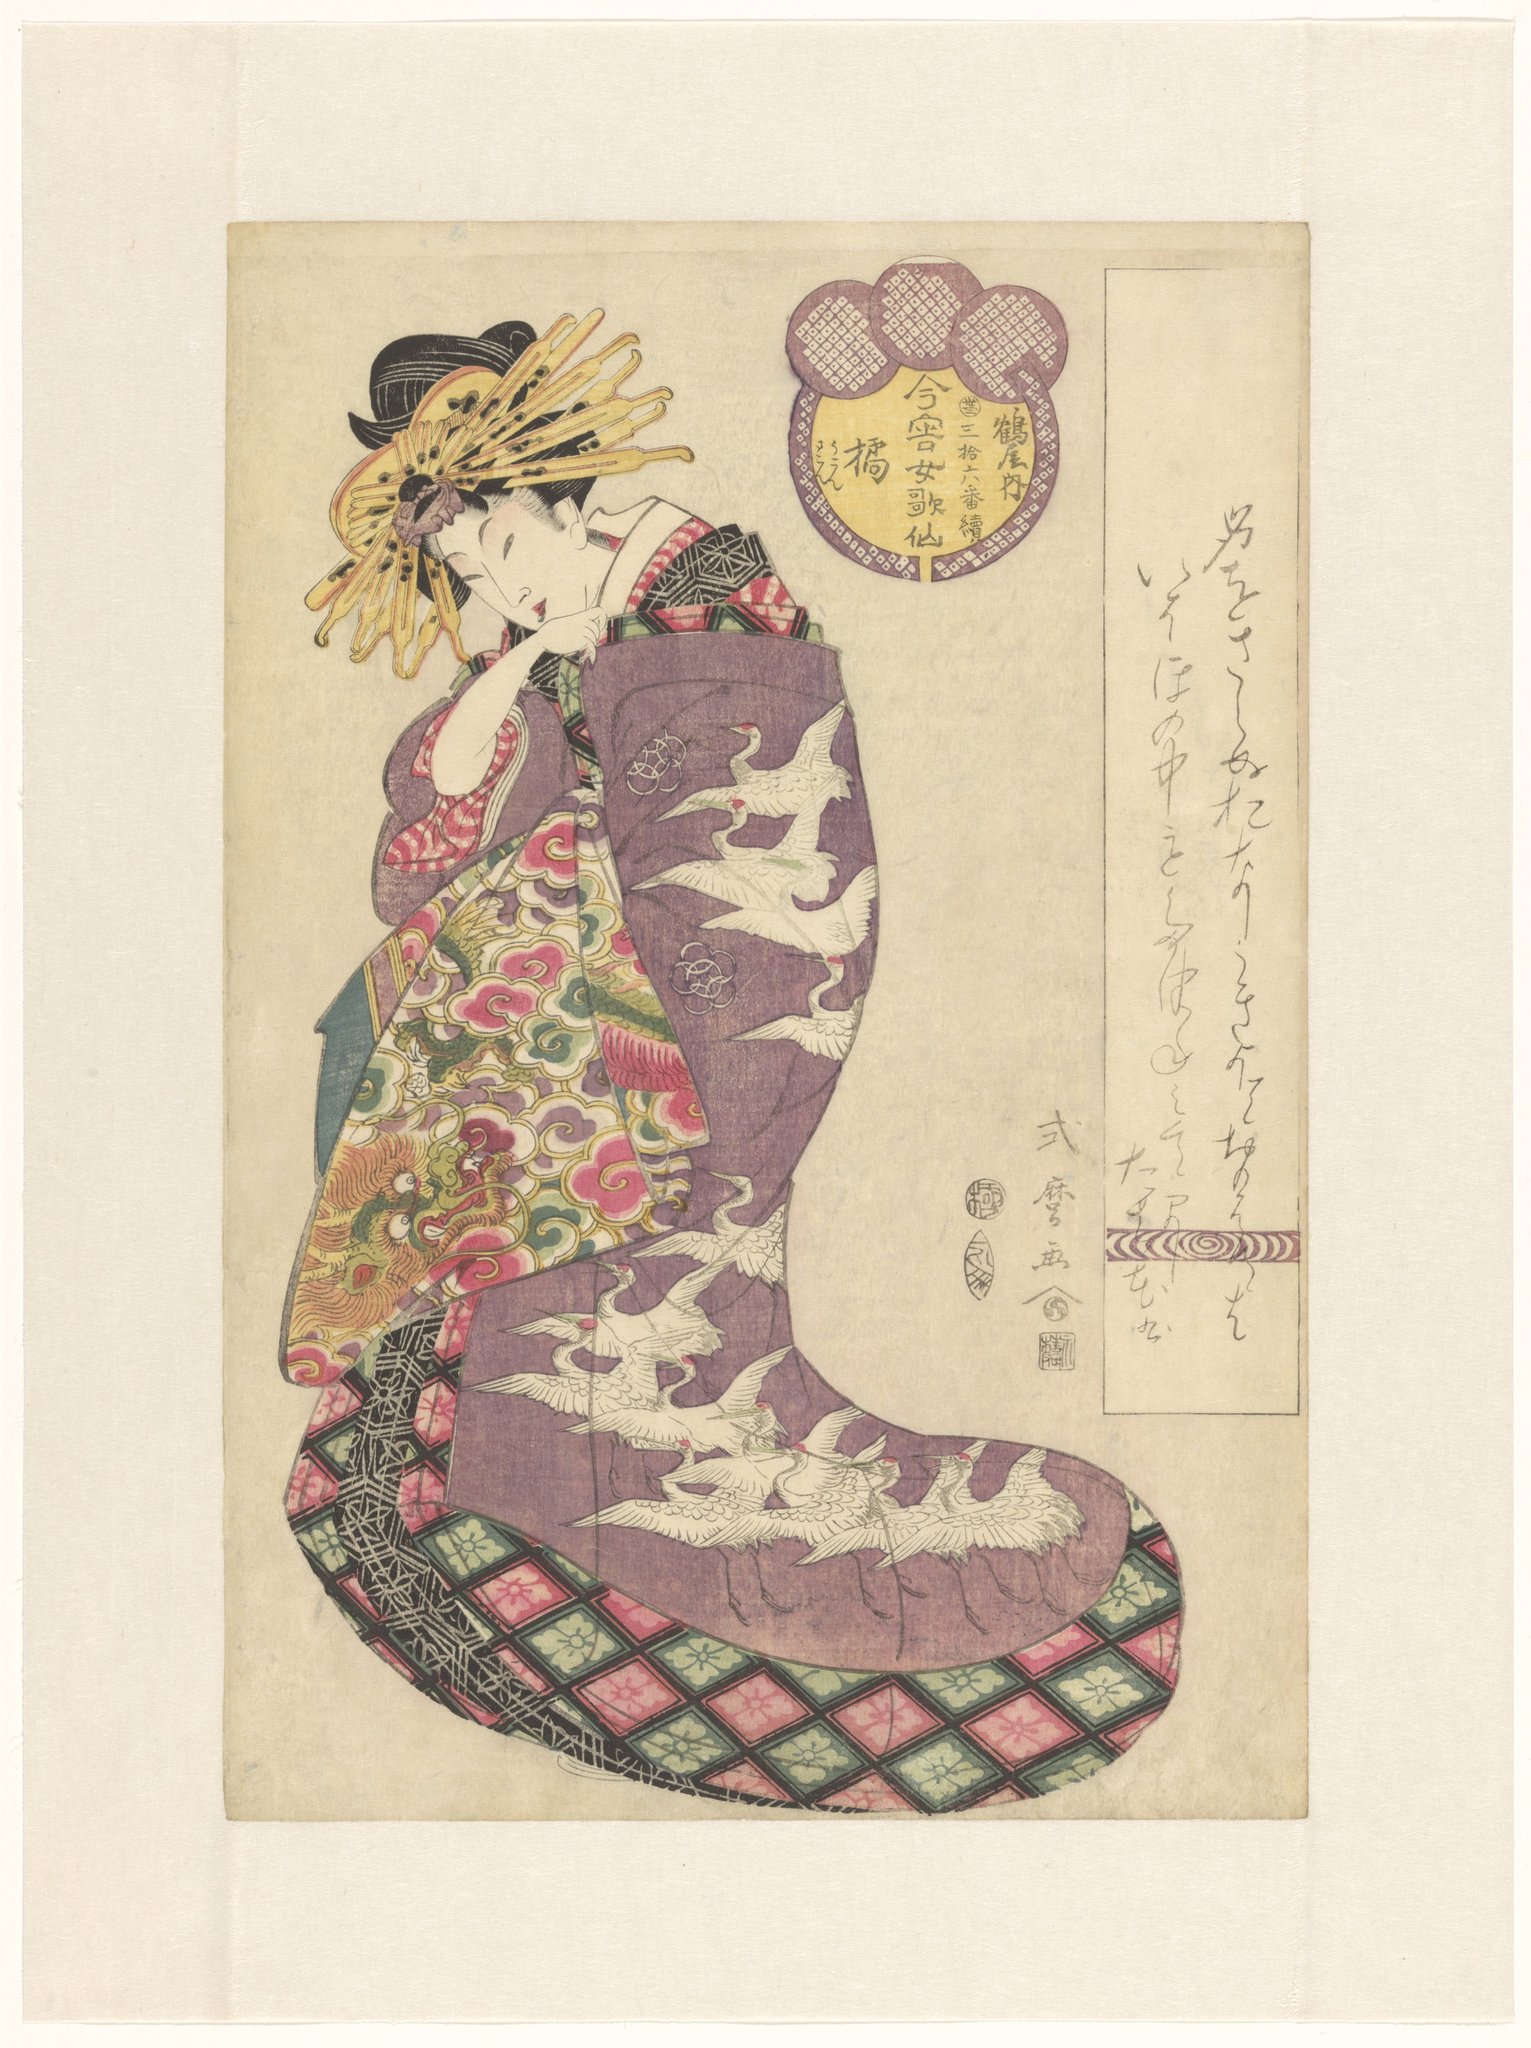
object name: print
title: Courtisane Tachibana uit het Tsuruya huis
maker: kitagawa shikimaro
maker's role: painter, print maker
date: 1813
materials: paper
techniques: woodcut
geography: japan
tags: historical persons - bb - woman, courtesan, hetaera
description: Een surimono is een luxe uitgevoerde prent waarop beeld met één of meerdere gedichten gecombineerd is. Bij het drukken van een surimono werd vaak gebruik gemaakt van dikker papier, blinddruk en metaal pigmenten, zoals koper- en zilverpoeder. De prenten werden vaak in opdracht van dichters gemaakt en als exclusief geschenk aan vrienden en relaties gegeven.